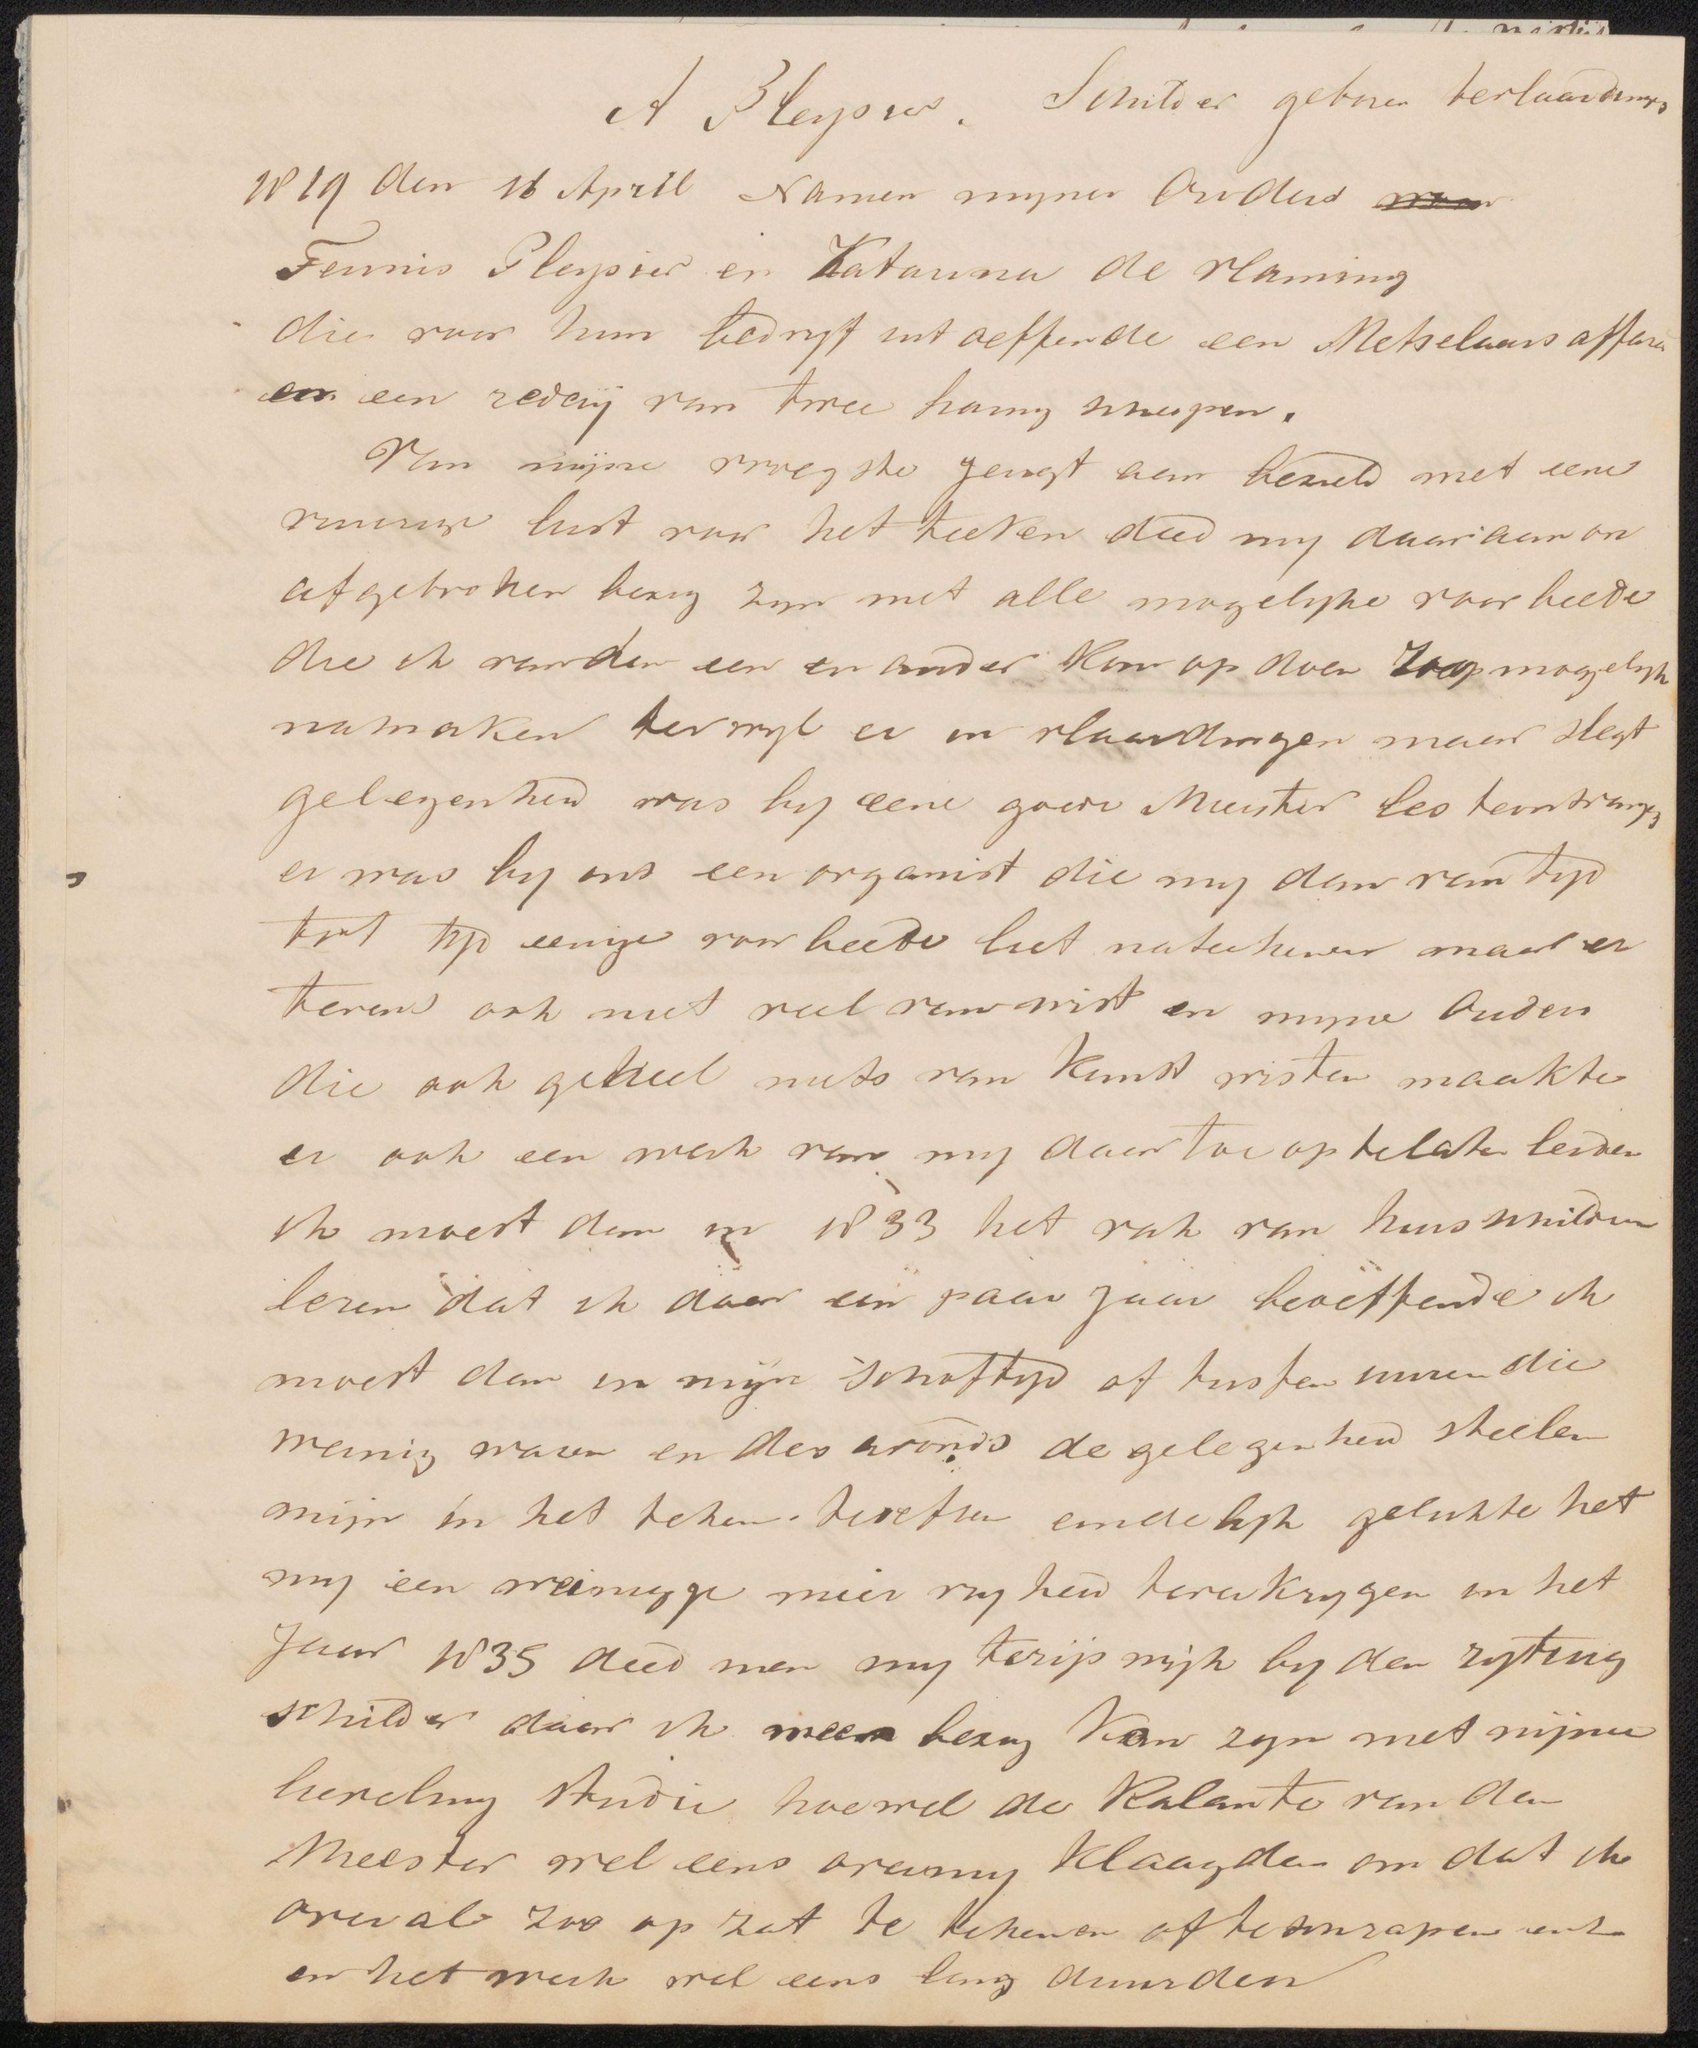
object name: letter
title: Brief aan anoniem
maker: ary pleijsier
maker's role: draughtsman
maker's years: 1819-1879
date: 1847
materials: ink, paper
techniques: pen, writing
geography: the hague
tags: painting (including book-illumination, miniature-painting)